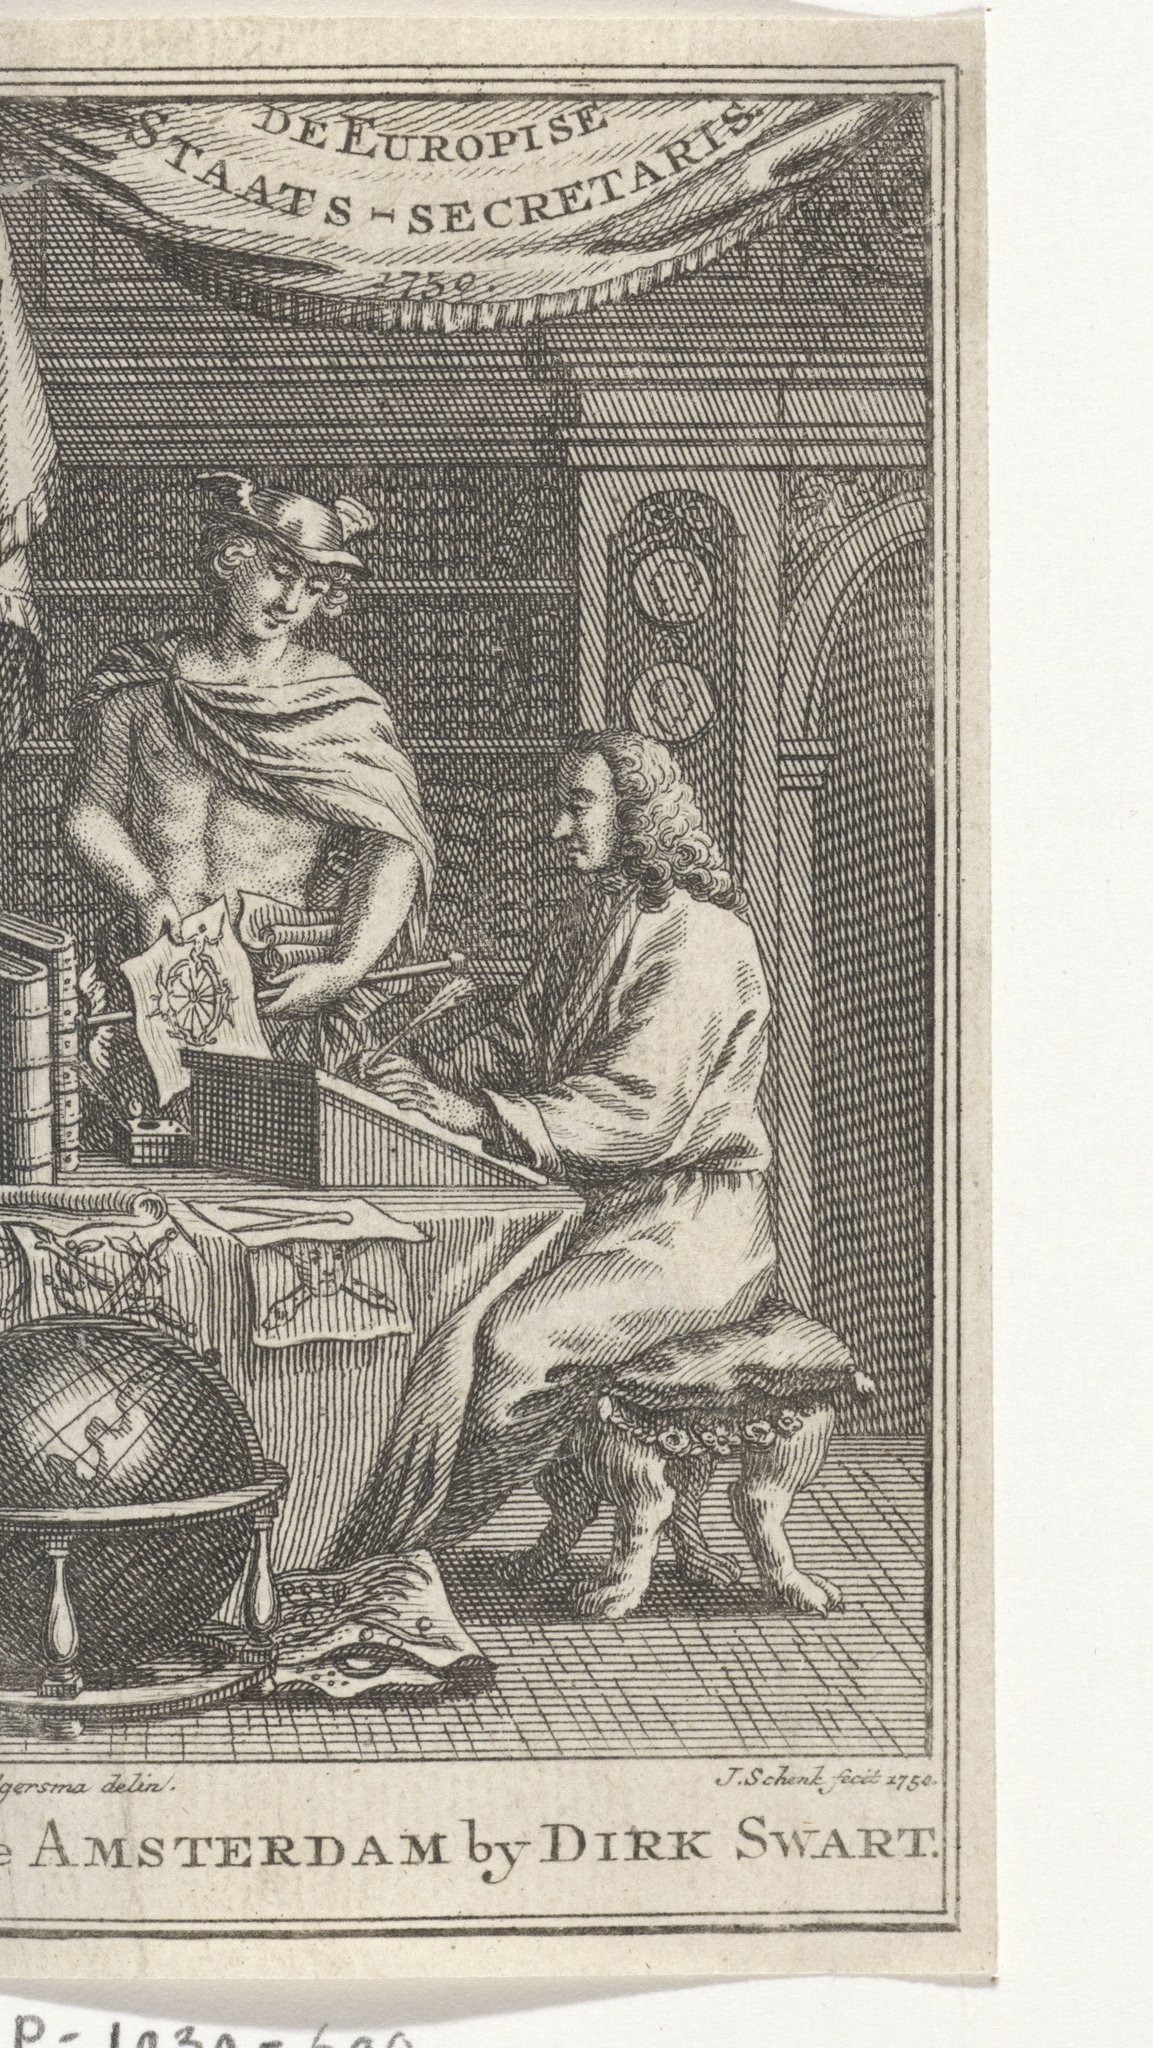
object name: print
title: Titelpagina voor: De Europise Staats-Secretaris, 1750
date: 1750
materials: paper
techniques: engraving, etching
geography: amsterdam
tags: handwriting, writing as activity, secretary of state, state secretary ~ government, study; 'studiolo'; library, specific aspects, allegorical aspects of mercury; mercury as patron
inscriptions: collector's mark: Lugt 2760, collector's mark: Lugt 2166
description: In een studeerkamer schrijft een man, de secretaris, aan een schrijftafel. Bij hem staat Mercurius, die hem een vel papier toont. Links een wereldbol en op de achtergrond een boekenkast. Boven een draperie met de titel.